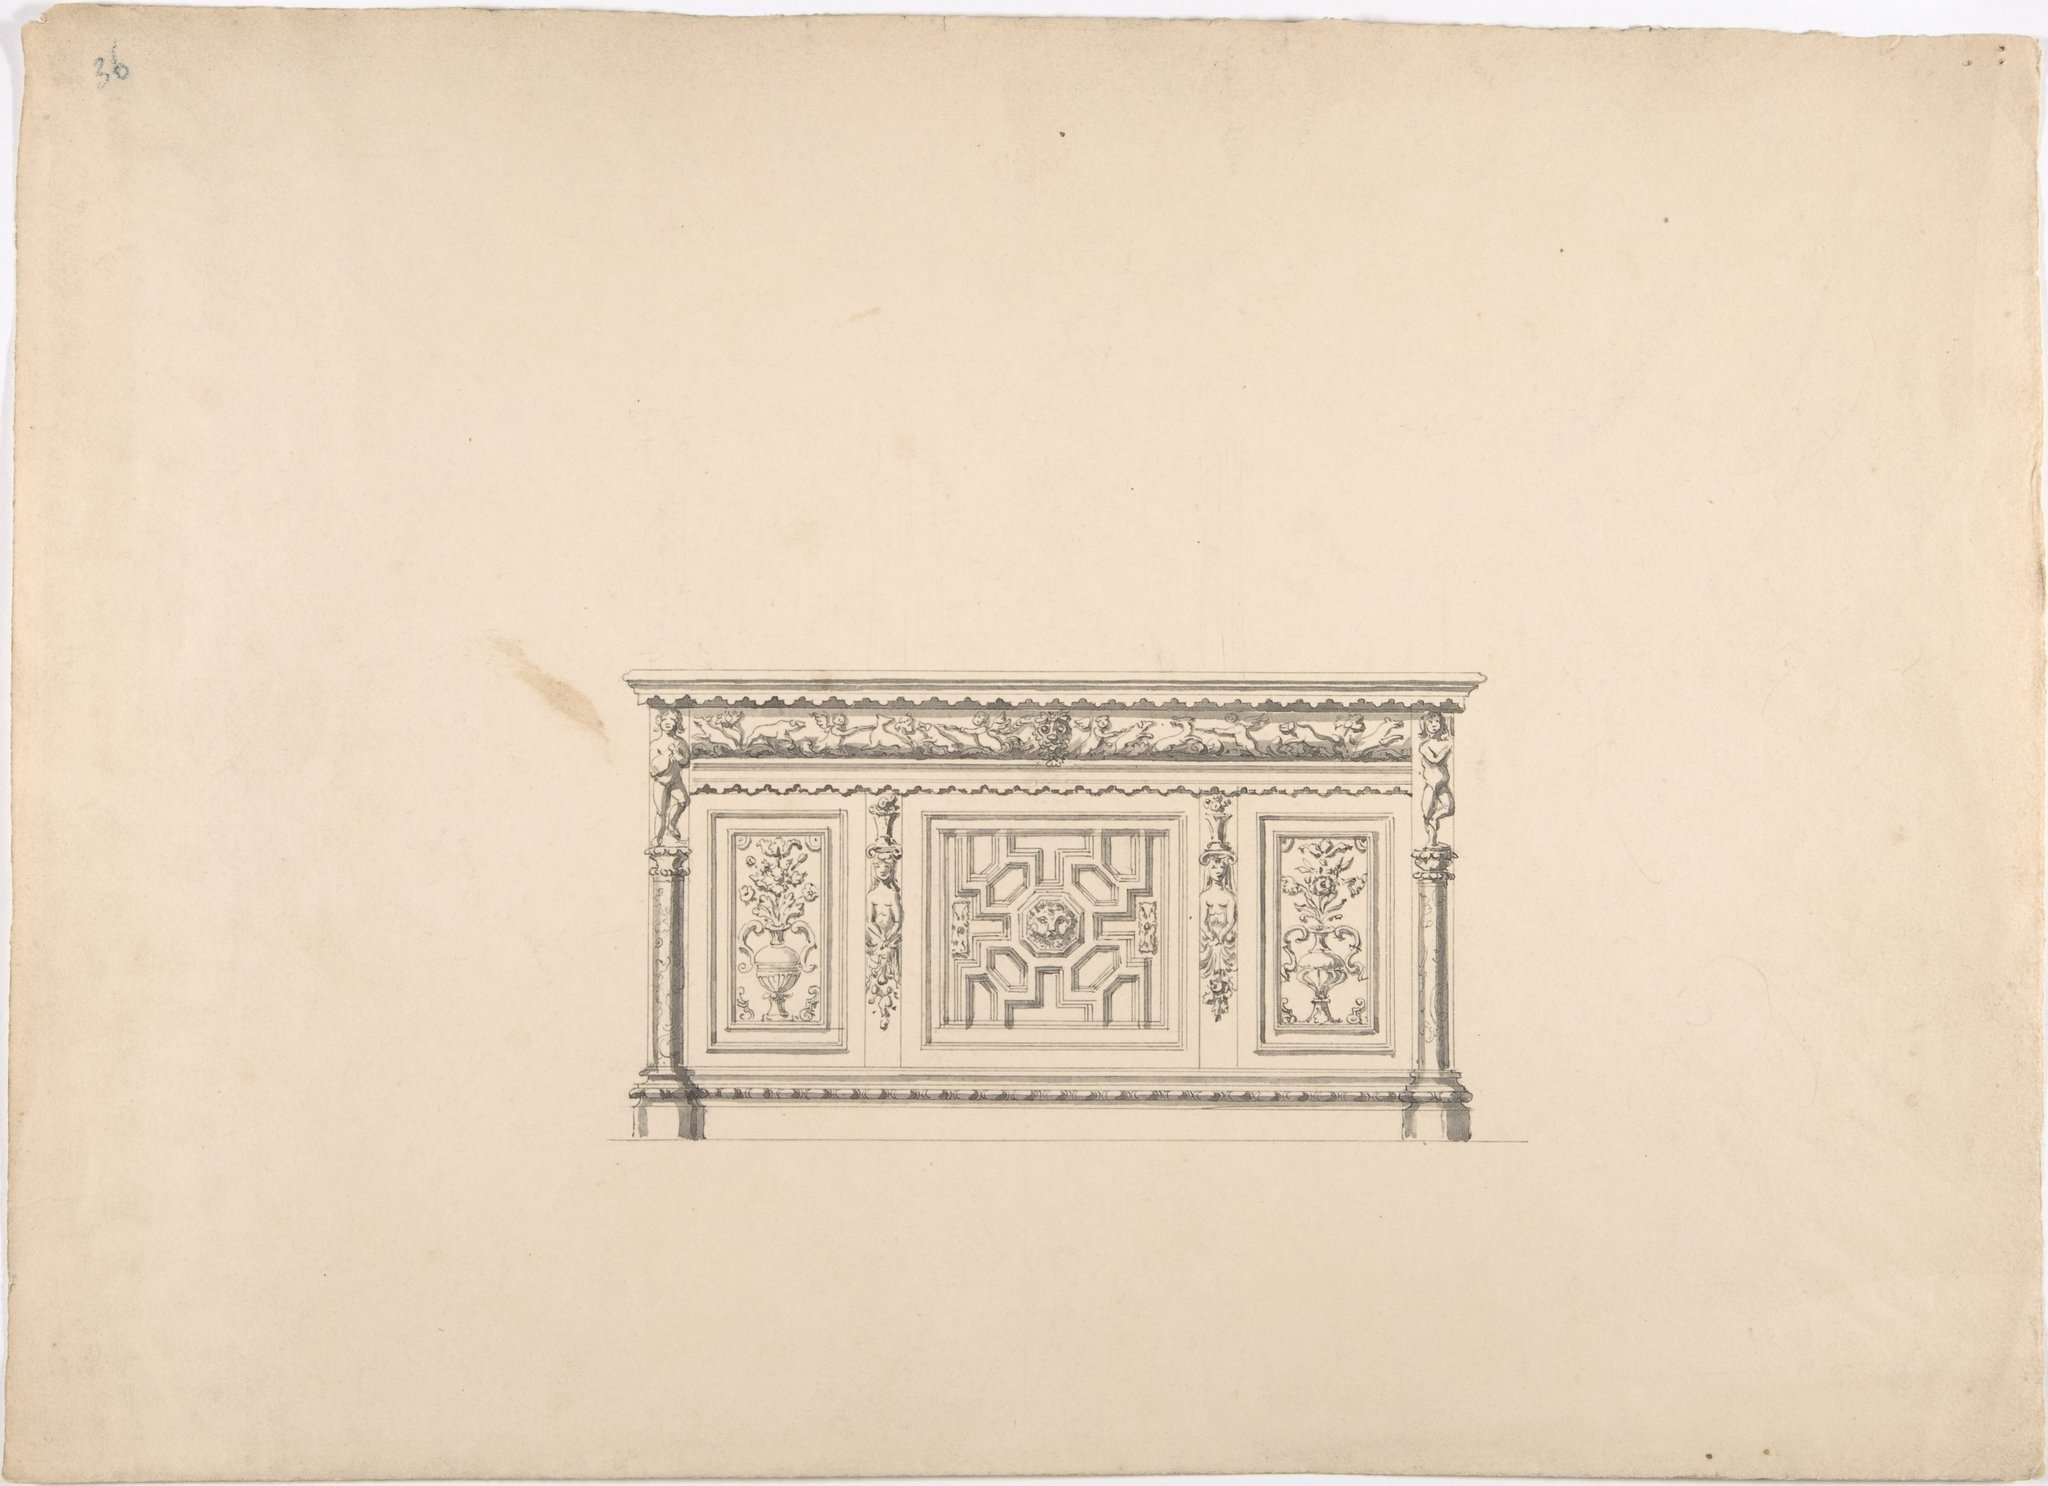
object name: drawing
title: Design for a Renaissance Style Carved Cabinet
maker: anonymous, british, 19th century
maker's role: artist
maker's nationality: british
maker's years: 1800-1900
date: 1801-1833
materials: ink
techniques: brush, pen, wash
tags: cabinets